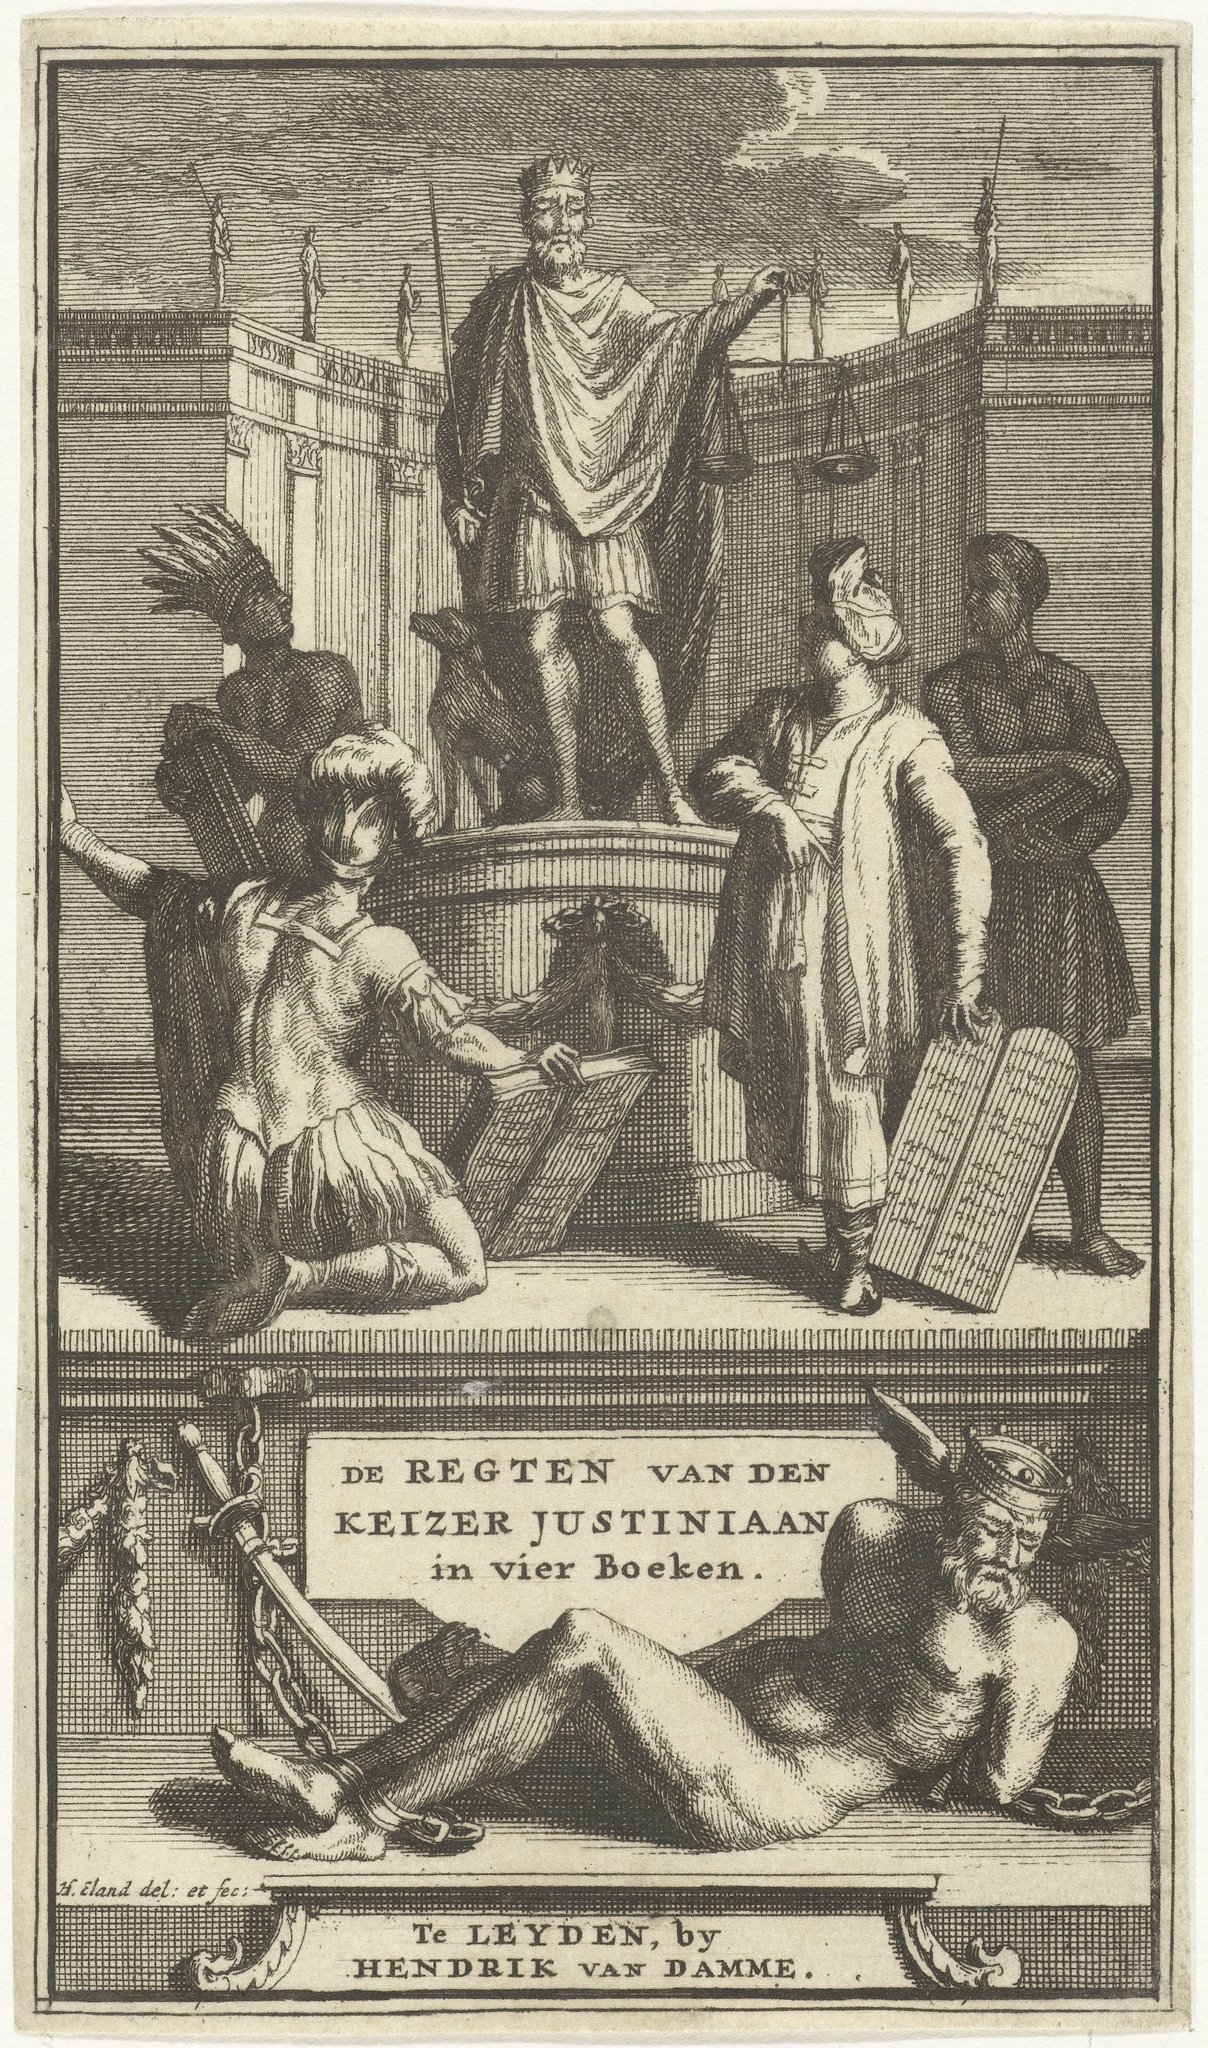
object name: print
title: de REGTEN van den KEIZER JUSTINIAAN in vier boeken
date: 1705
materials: paper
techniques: etching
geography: amsterdam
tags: macedonië, constantinopel, keizer, justinianus i (keizer van het byzantijnse rijk)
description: Keizer Justinianus, op sokkel, met weegschaal en lans in handen en hond aan de voeten, wordt omringd door personificaties van de werelddelen Europa, Afrika, Azië en Amerika. Onderaan ligt een naakte geketende man met een gevleugelde kroon op en een klein dier op z'n been.